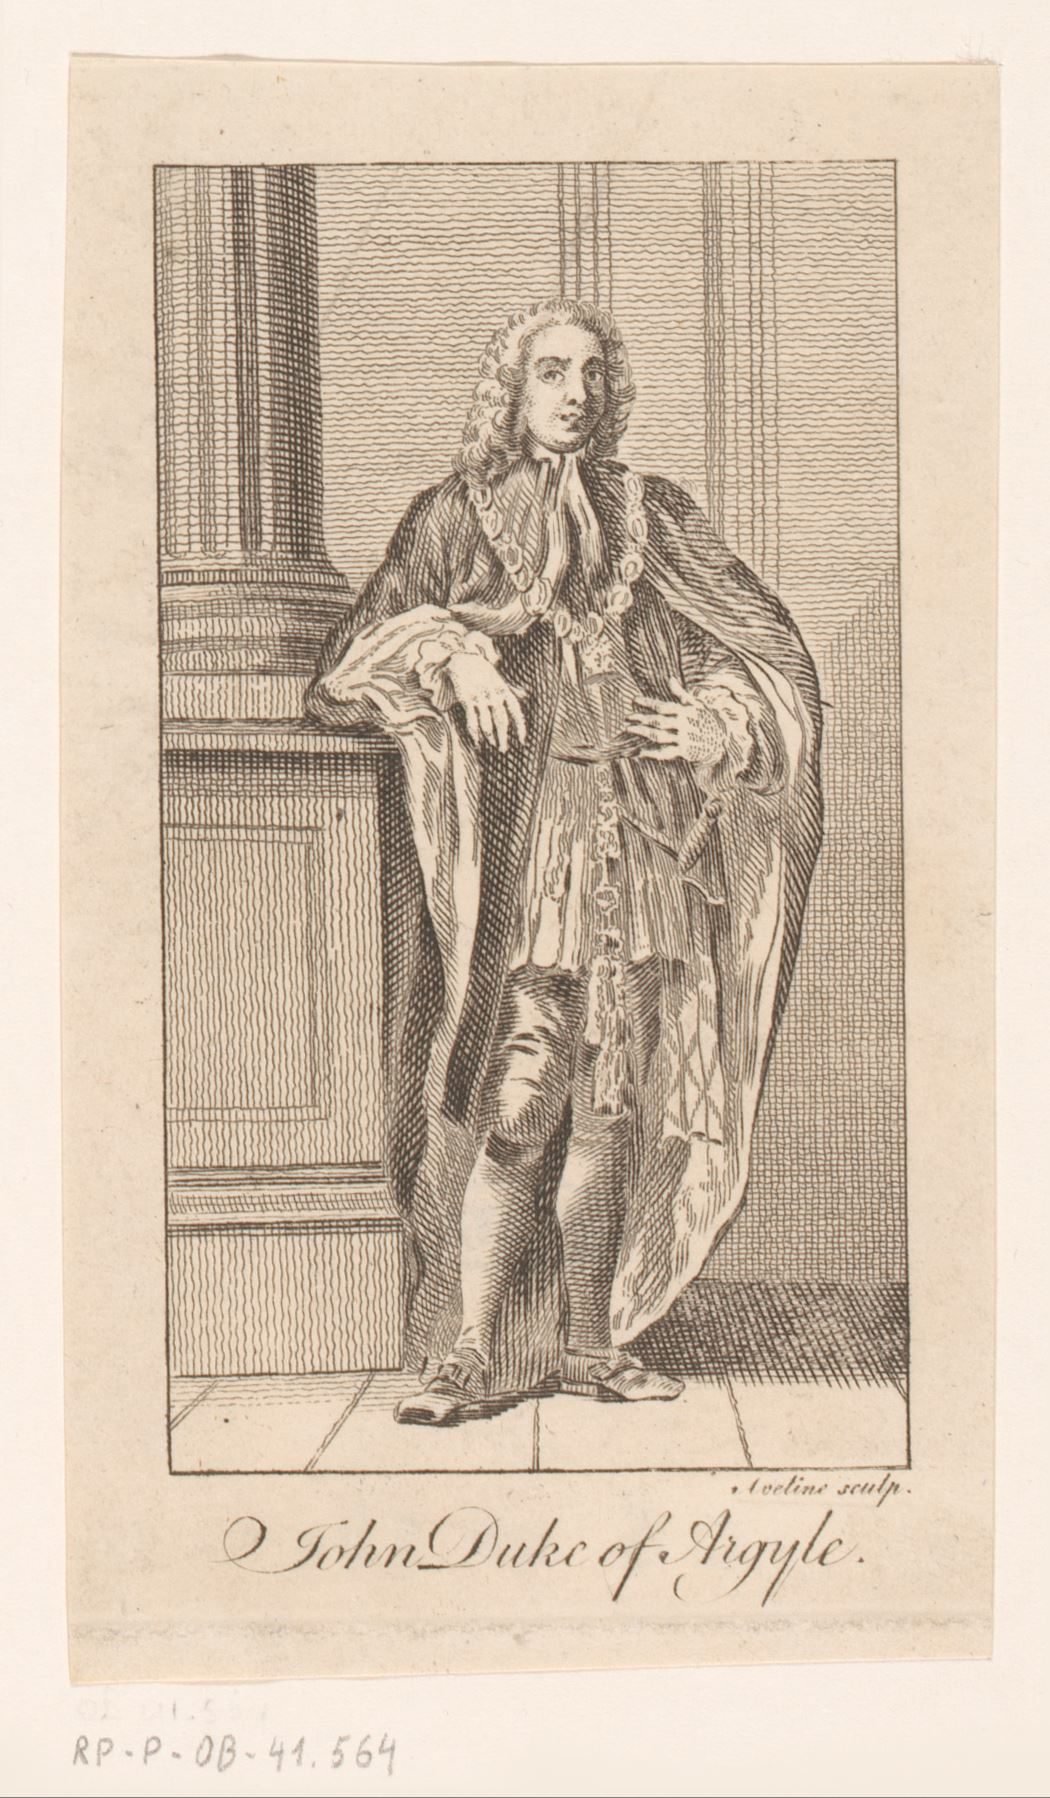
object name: print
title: Portret van John Campbell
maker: françois-antoine aveline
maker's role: print maker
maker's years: 1718-1780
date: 1728-1780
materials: paper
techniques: etching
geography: france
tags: historical persons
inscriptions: collector's mark: Lugt 2228